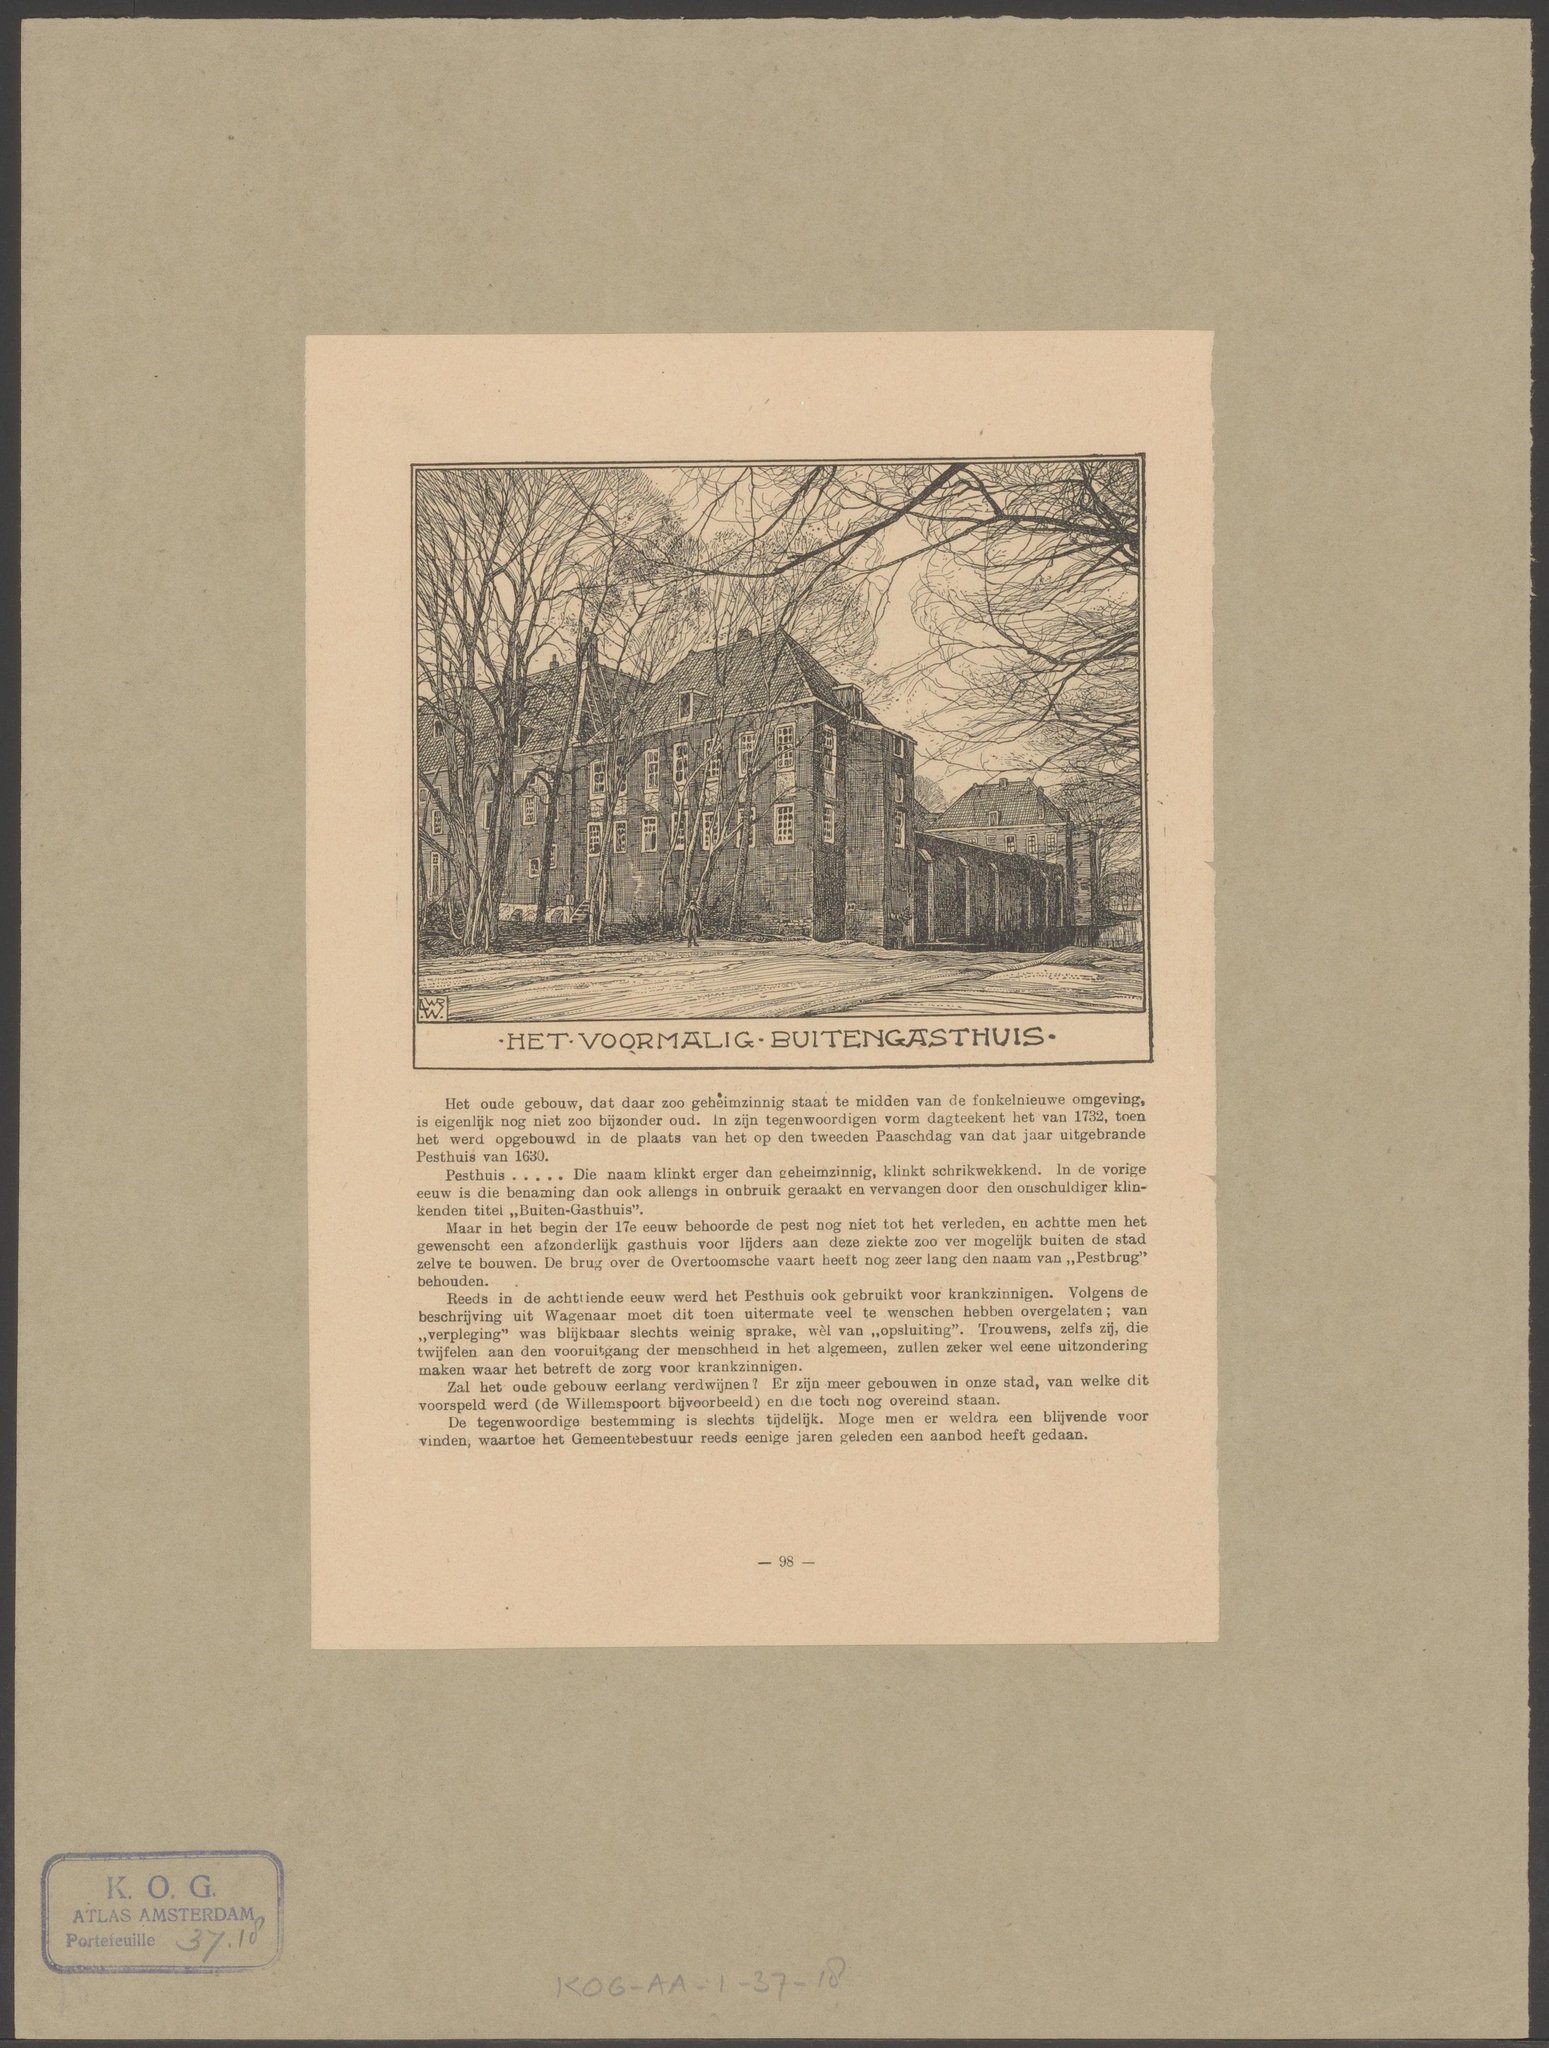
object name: book illustration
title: Gezicht op het Buitengasthuis te Amsterdam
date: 1907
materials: paper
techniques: letterpress printing, line block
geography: amsterdam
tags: hospital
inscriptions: collector's mark: Lugt 1641b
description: Onderwerpsrubriek binnen de Atlas Amsterdam: Armwezen en liefdadige instellingen: I. Stadsinrichtingen: Buitengasthuis (Pesthuis).